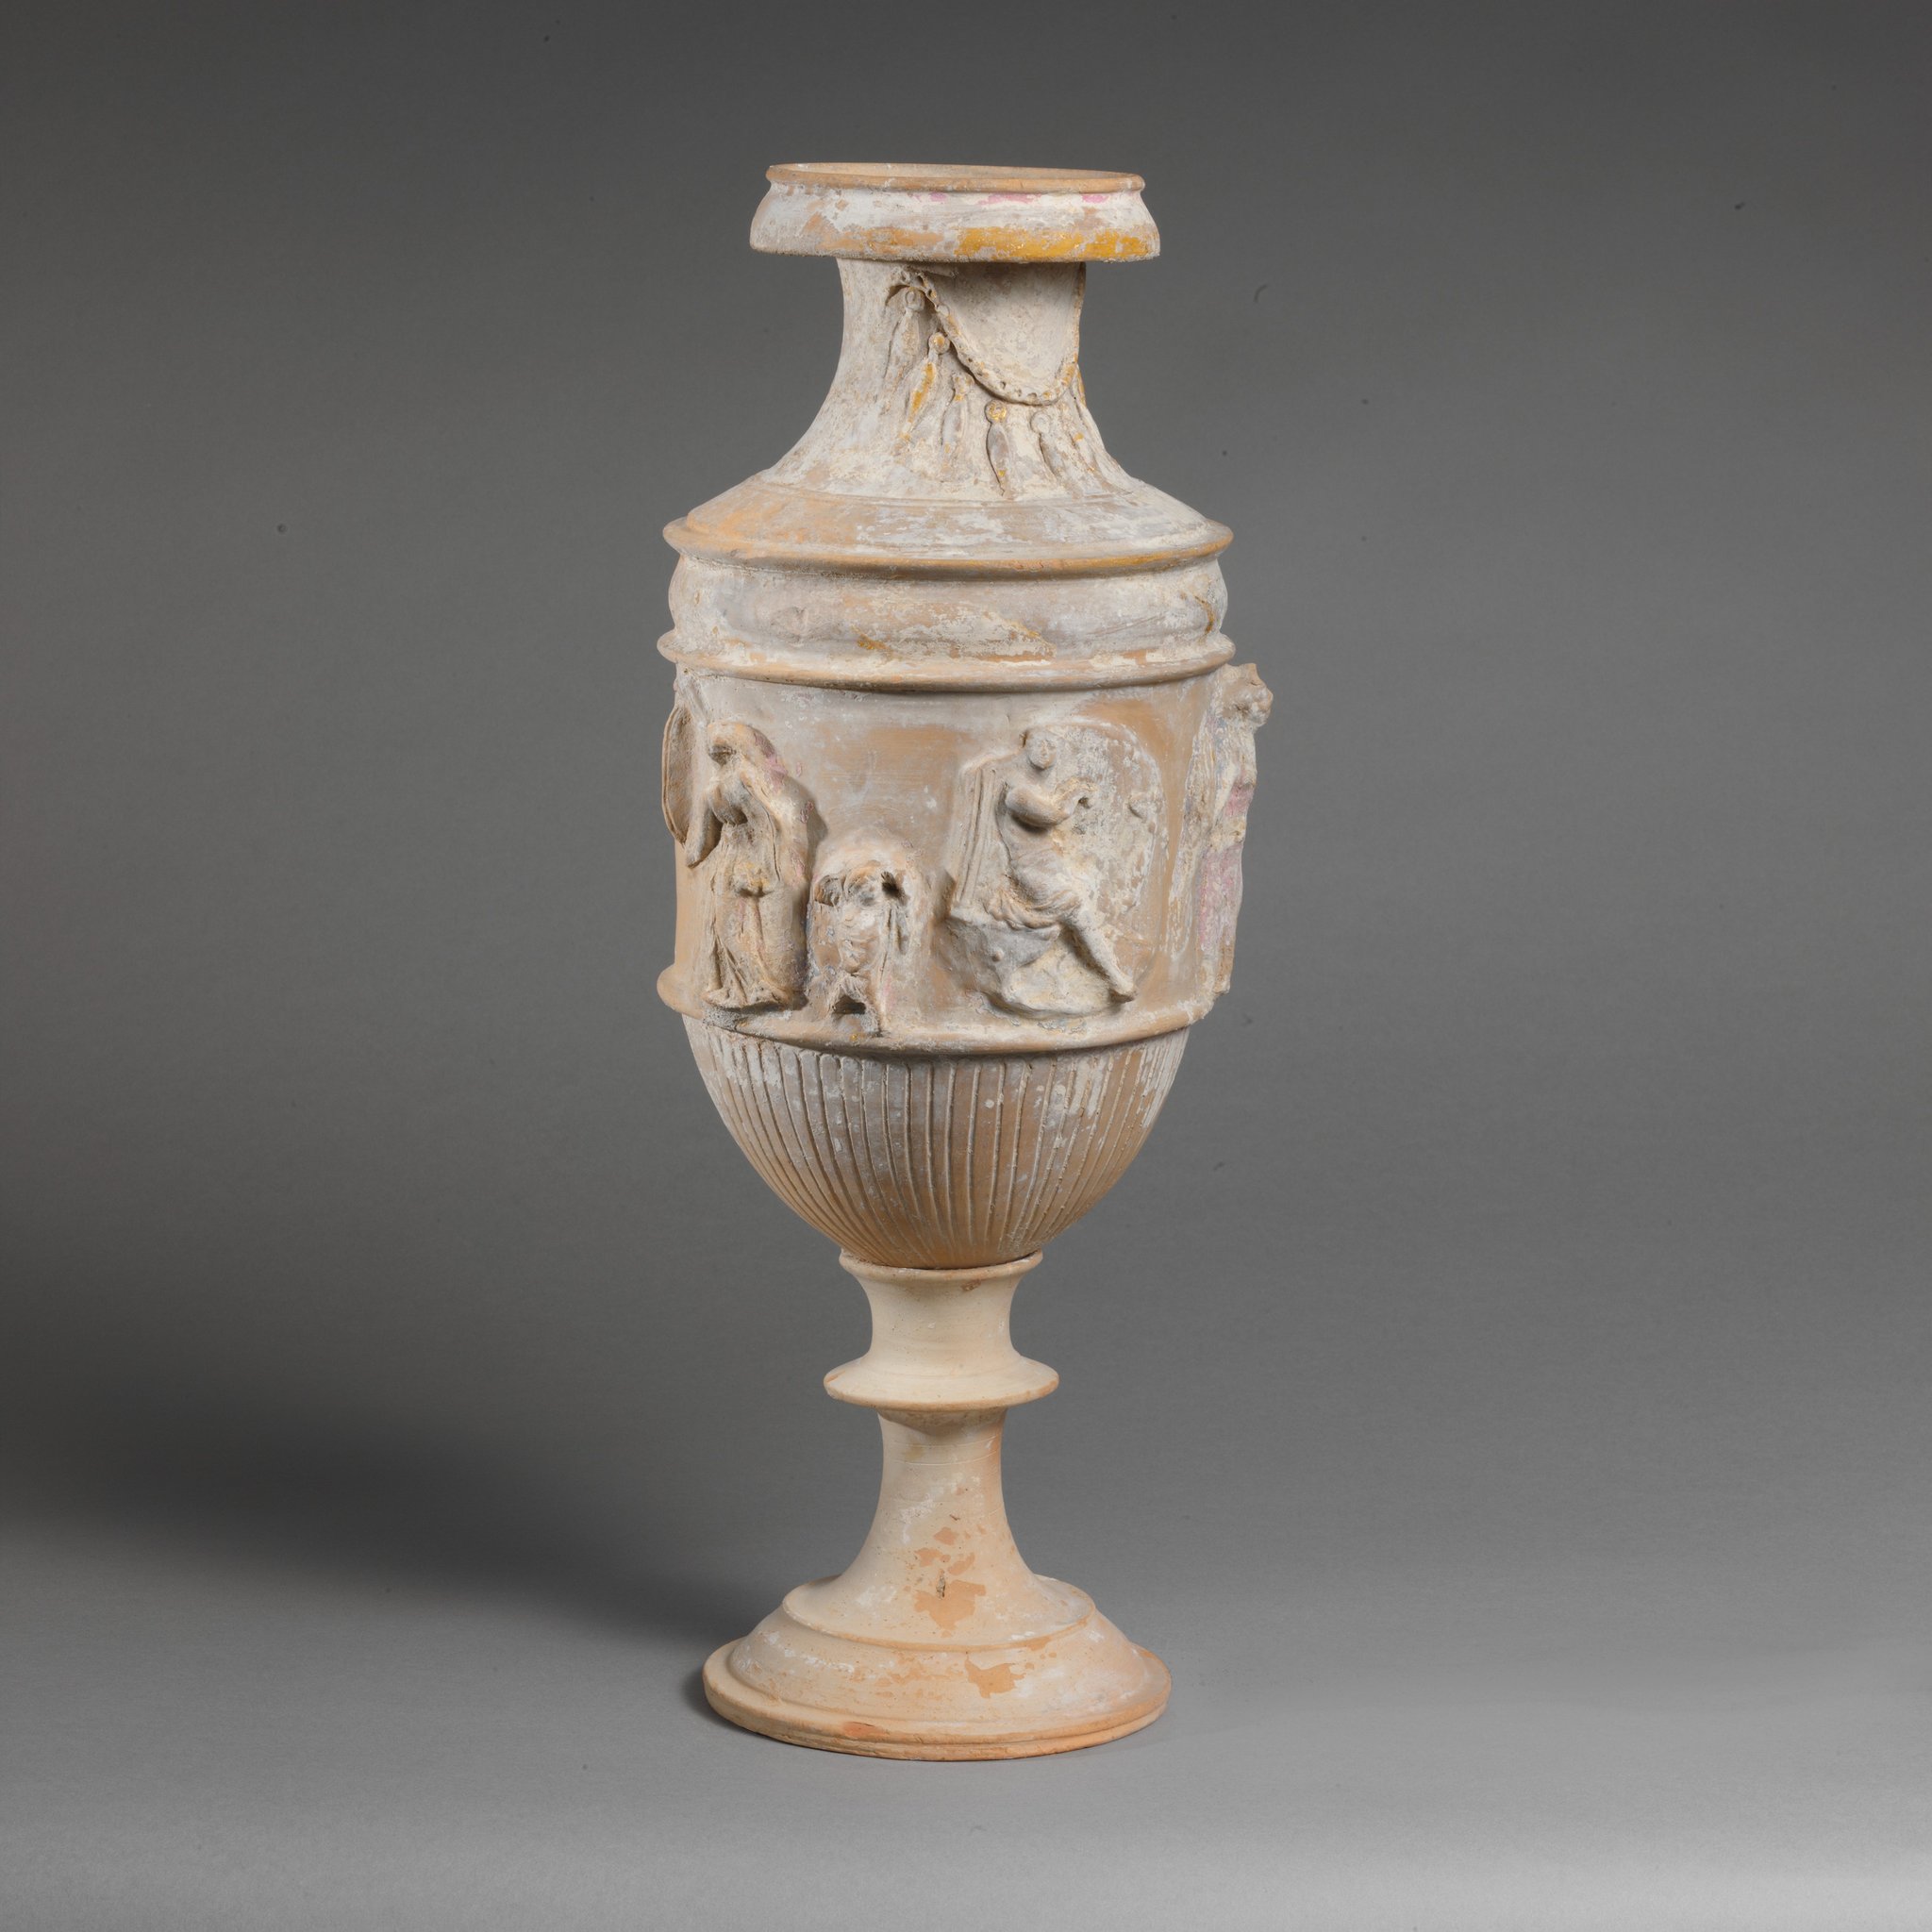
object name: vase with lid on stand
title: Terracotta vase with relief decoration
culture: greek, south italian, tarentine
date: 200-151 BCE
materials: terracotta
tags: athena,eros,nike